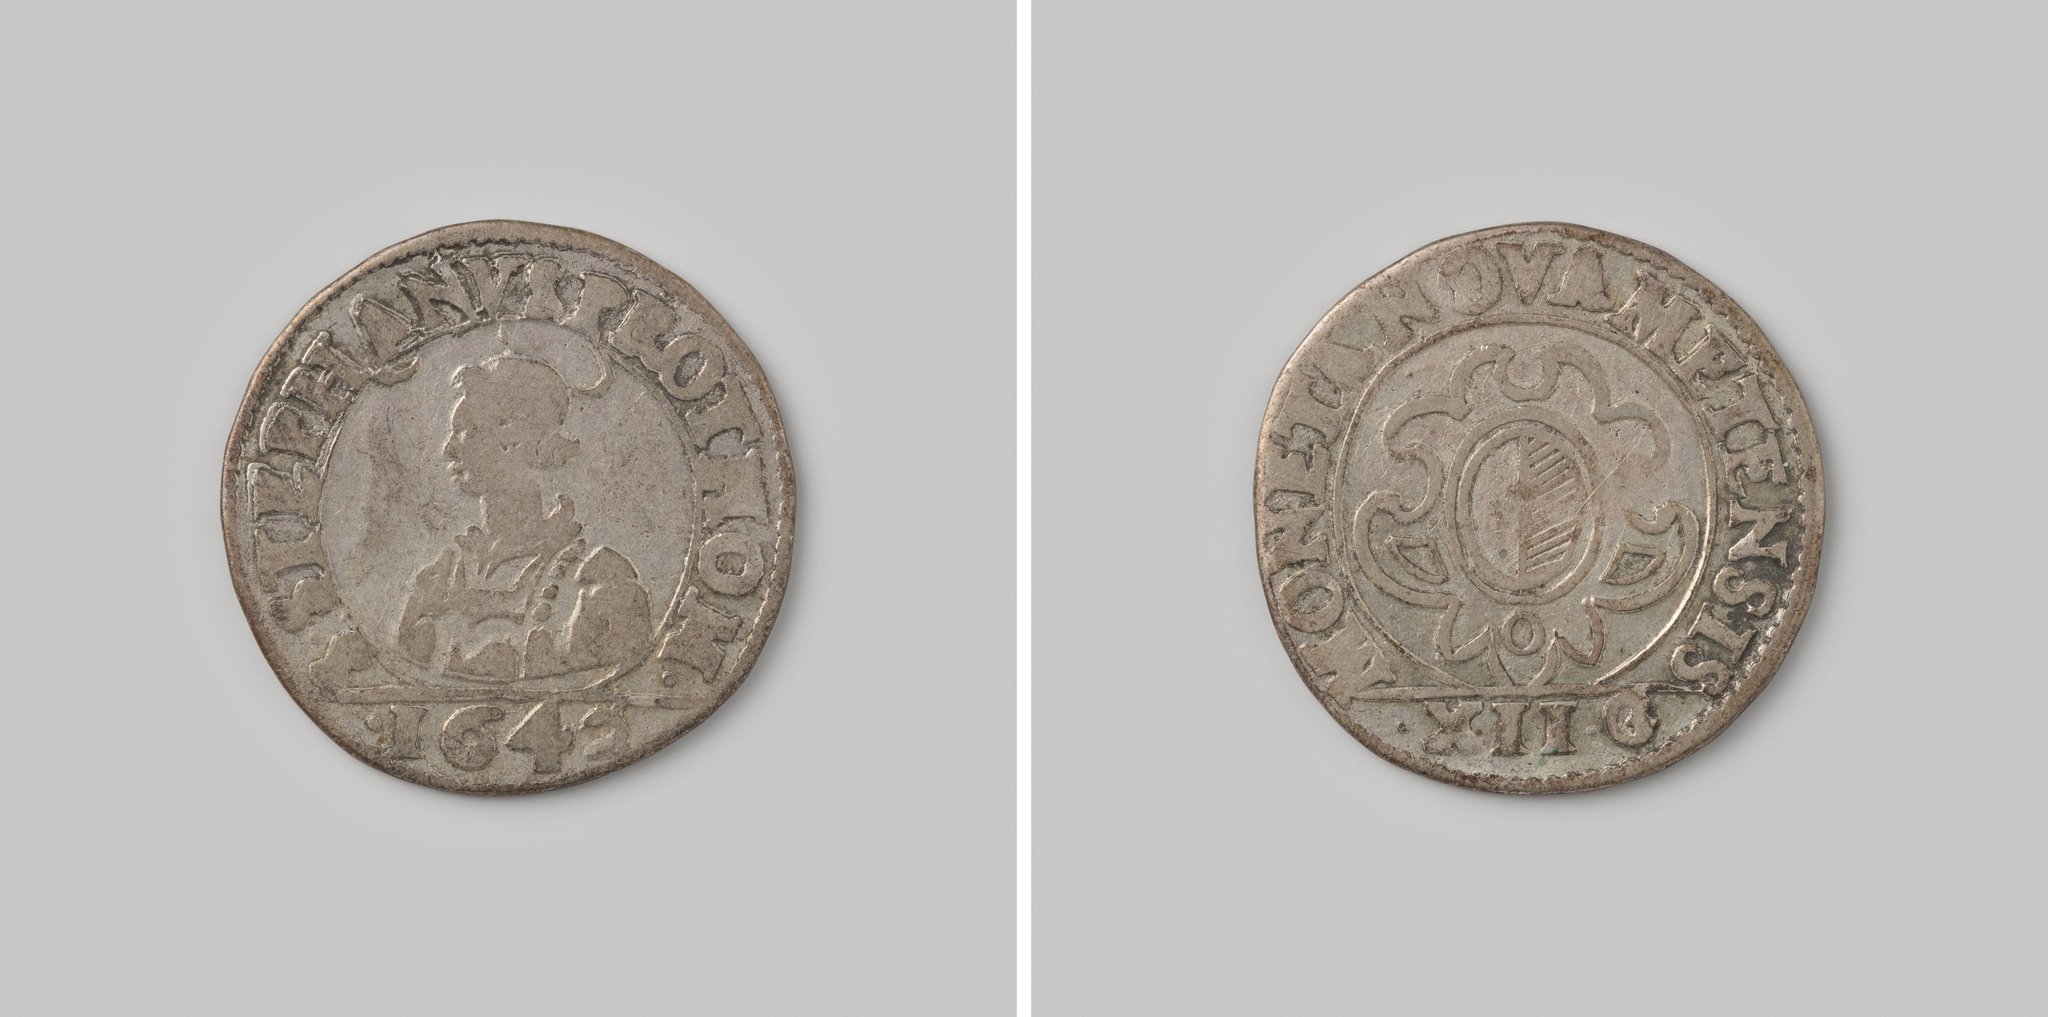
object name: frank, franc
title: Stad Metz, 12 Groschen of franc, 1642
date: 1642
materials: silver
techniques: striking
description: Zilveren munt. Voorzijde: borstbeeld van de heilige Stephanus naar links. In afsnede jaartal. Keerzijde: versierd wapenschild van de stad. In afsnede waarde-aanduiding: XII G..